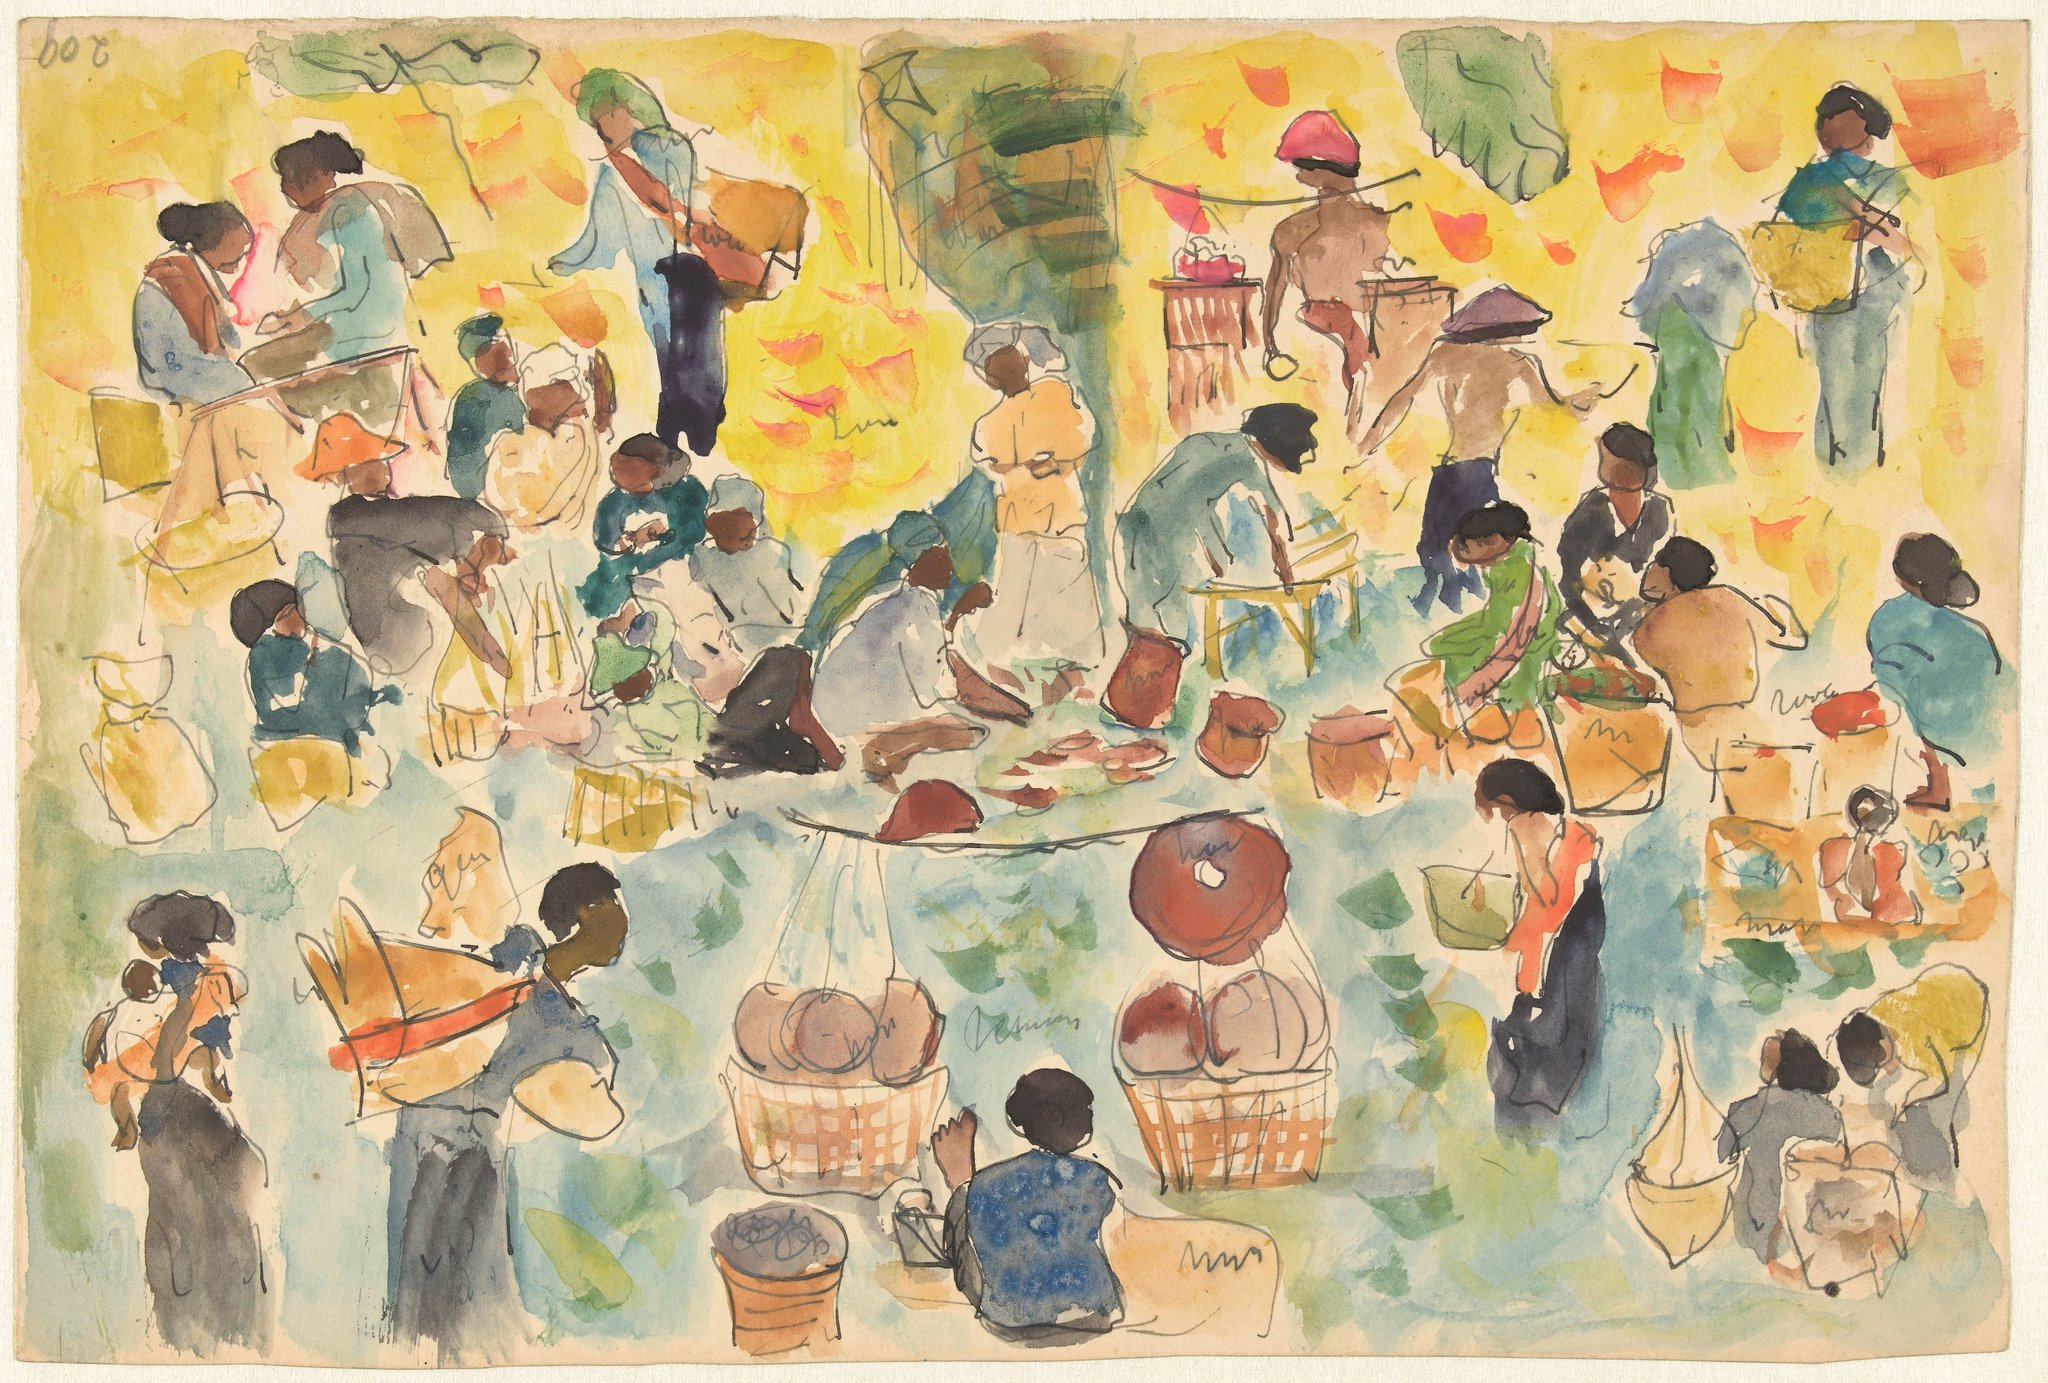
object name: drawing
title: Markttafereel in Nederlands-Indië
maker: pierre jean apol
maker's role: draughtsman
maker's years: 1876-1947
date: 1886-1947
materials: ink, paper, watercolor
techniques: brush, pen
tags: market, dutch east indies, the